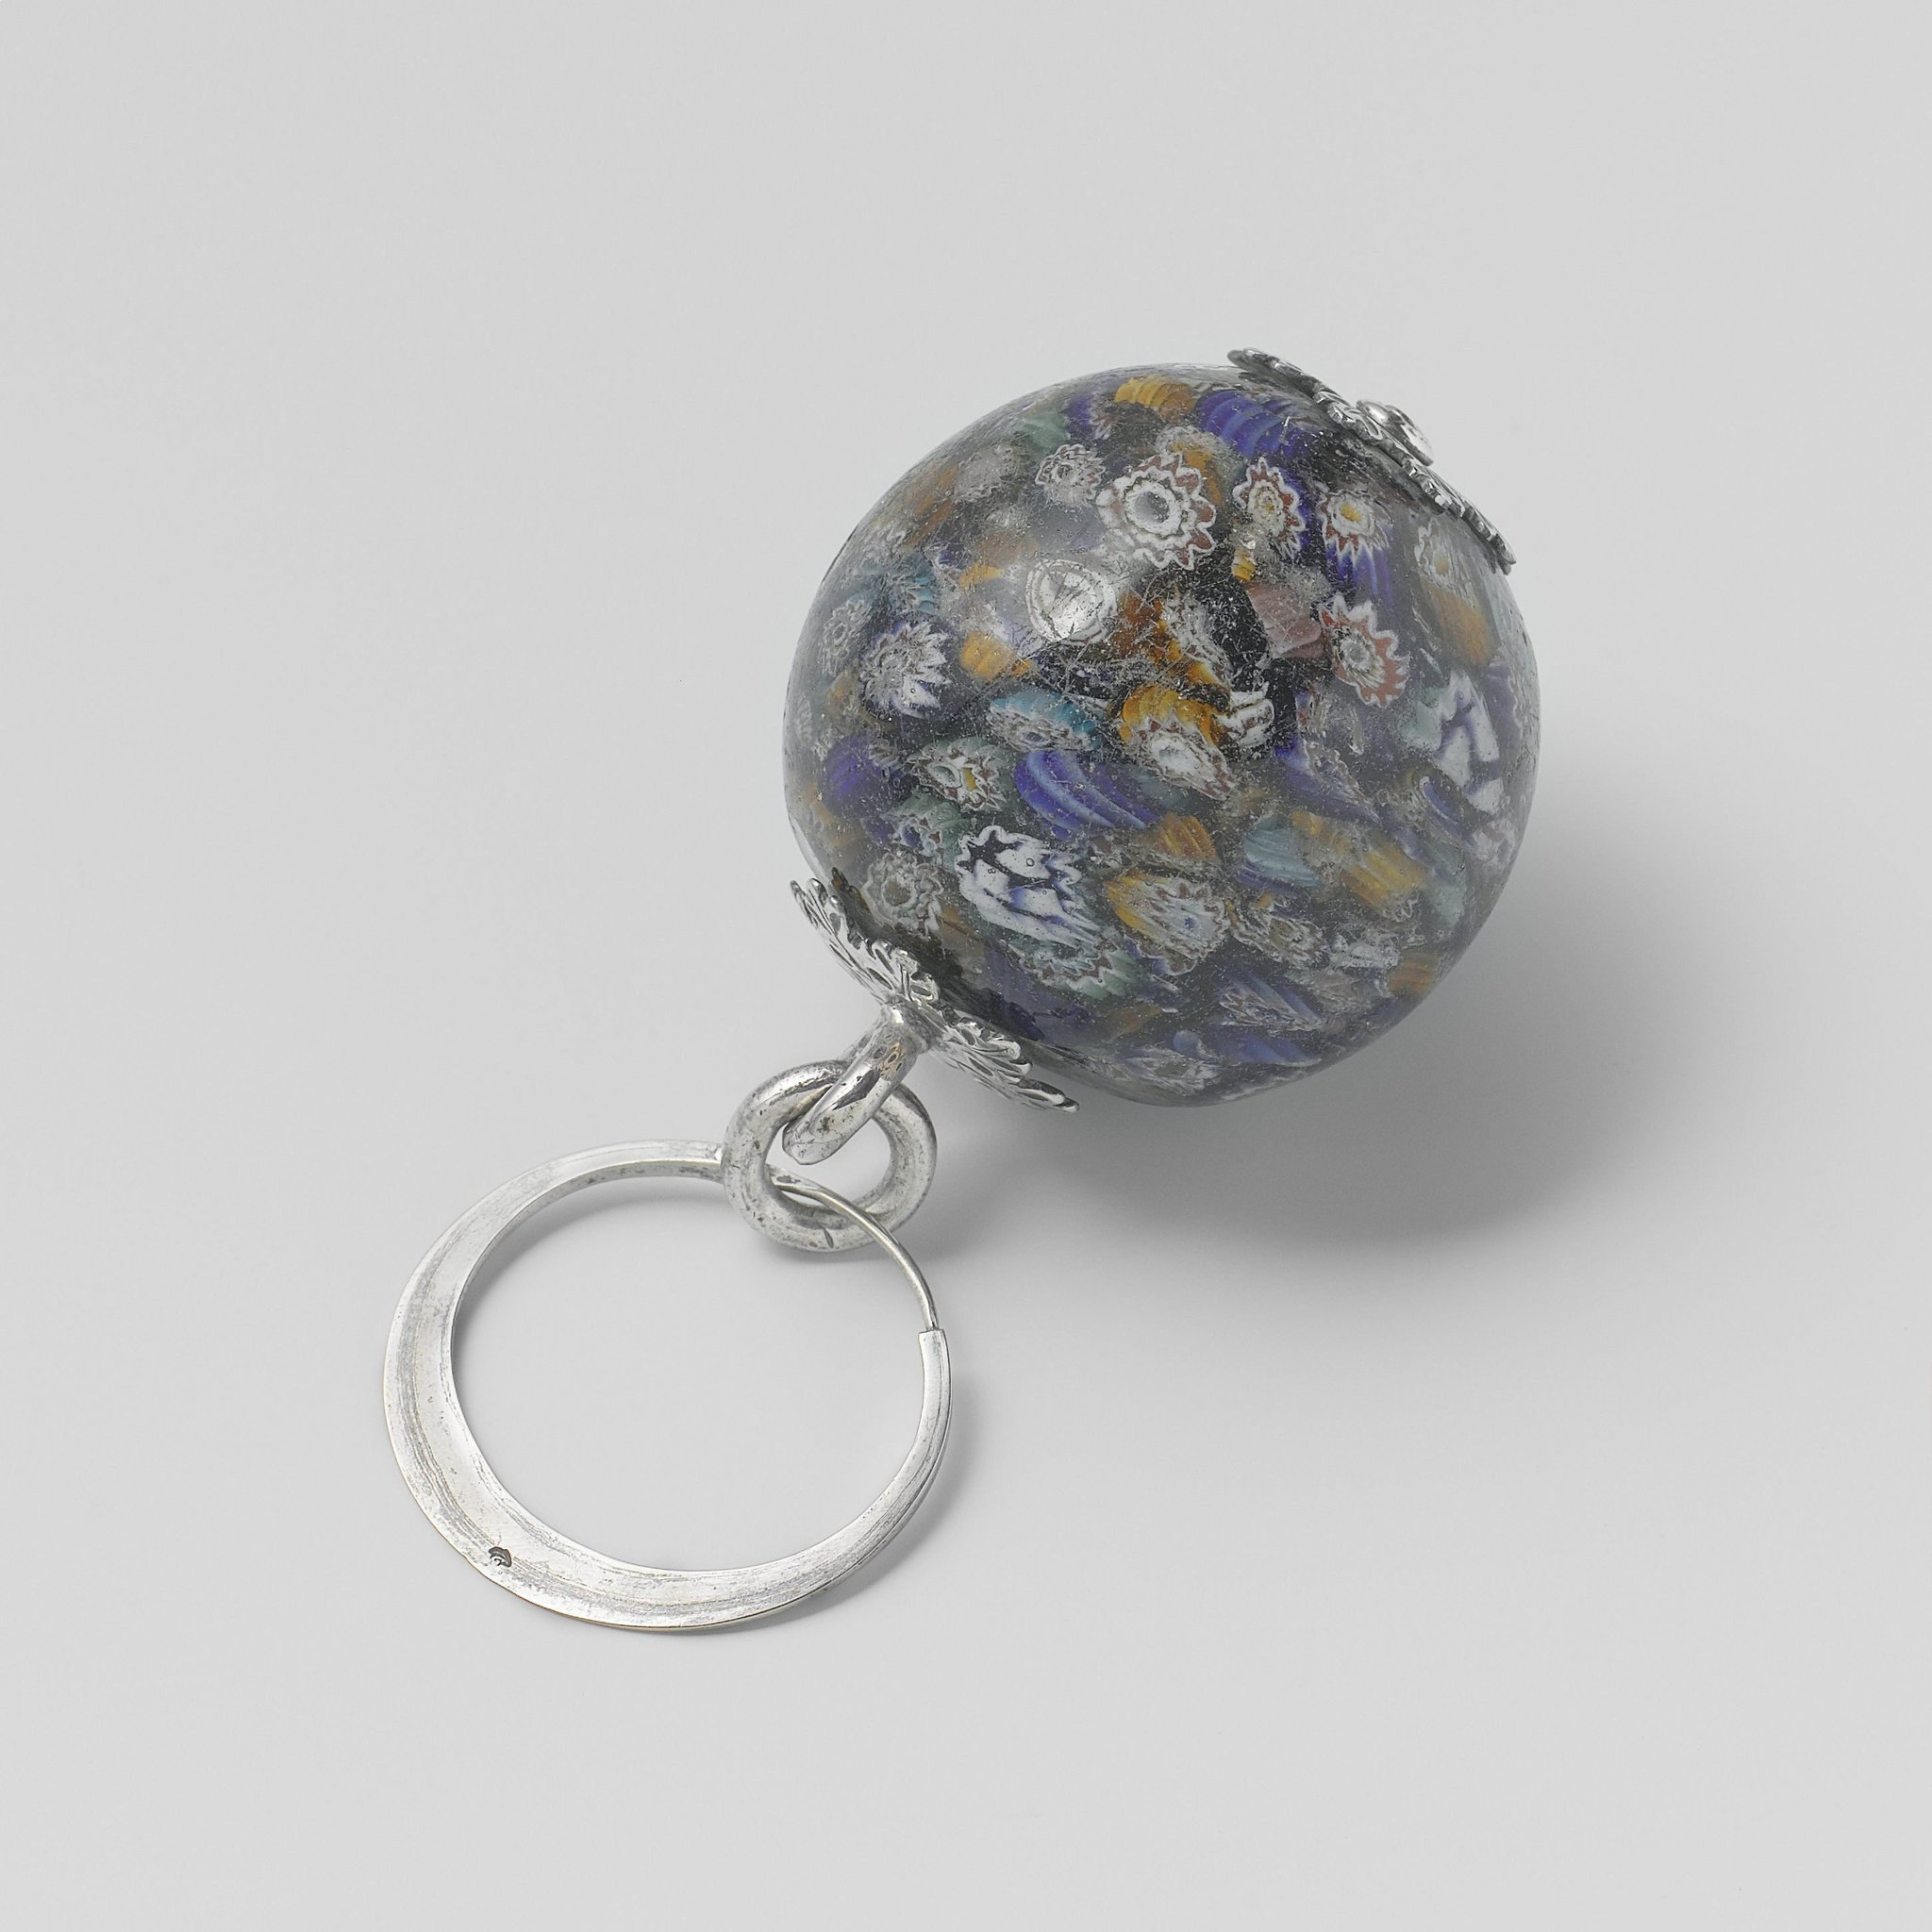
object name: sphere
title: Bol van millefioriglas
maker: Anonymous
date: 1500-1600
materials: glass, silver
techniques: glassblowing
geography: venice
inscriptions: duty mark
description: Bol van millefioriglas, doorboord en voorzien van een zilveren pen met oog, waaraan een platte zilveren ring is bevestigd die geopend kan worden. Een zilveren rozet aan beide zijden van het pennegat.